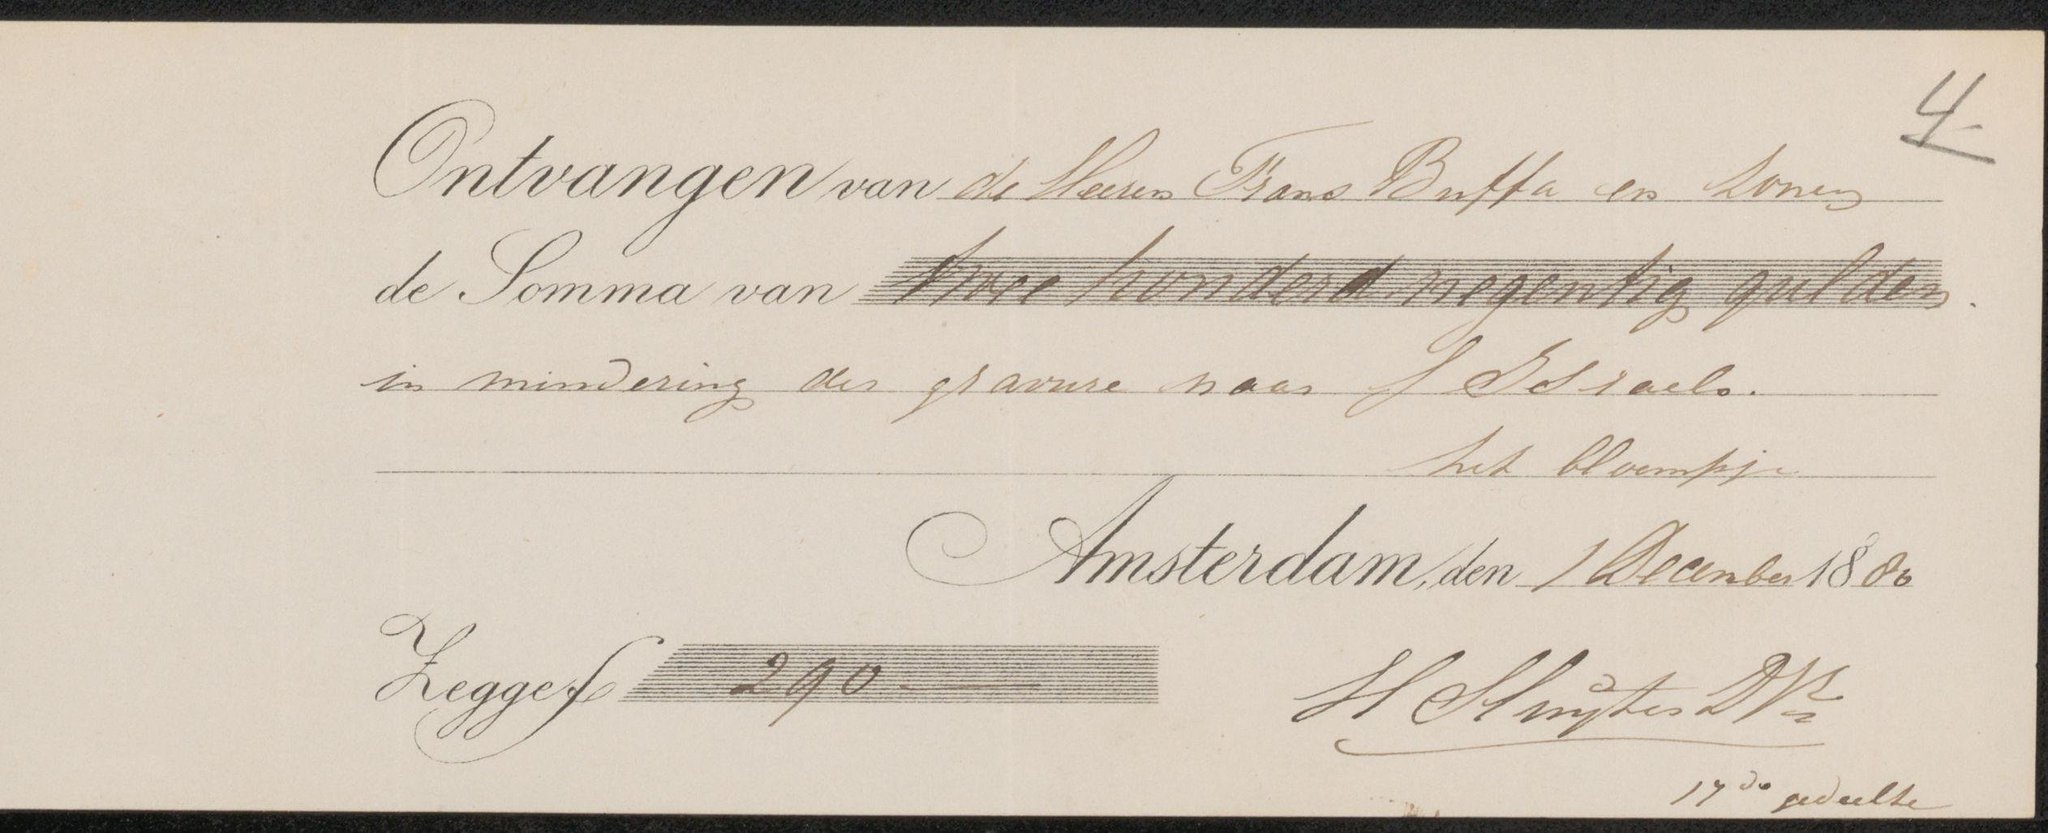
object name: ontvangstbewijs, kwitantie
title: Kwitantie voor Hendrik D. Jzn Sluyter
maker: hendrik d. jzn sluyter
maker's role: print maker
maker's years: 1839-1931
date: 1880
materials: ink, paper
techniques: pen, printing, writing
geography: amsterdam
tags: the hague, painter, print maker, draughtsman, jozef israëls, publisher, the graphic arts, money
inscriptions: collector's mark: Lugt 2233